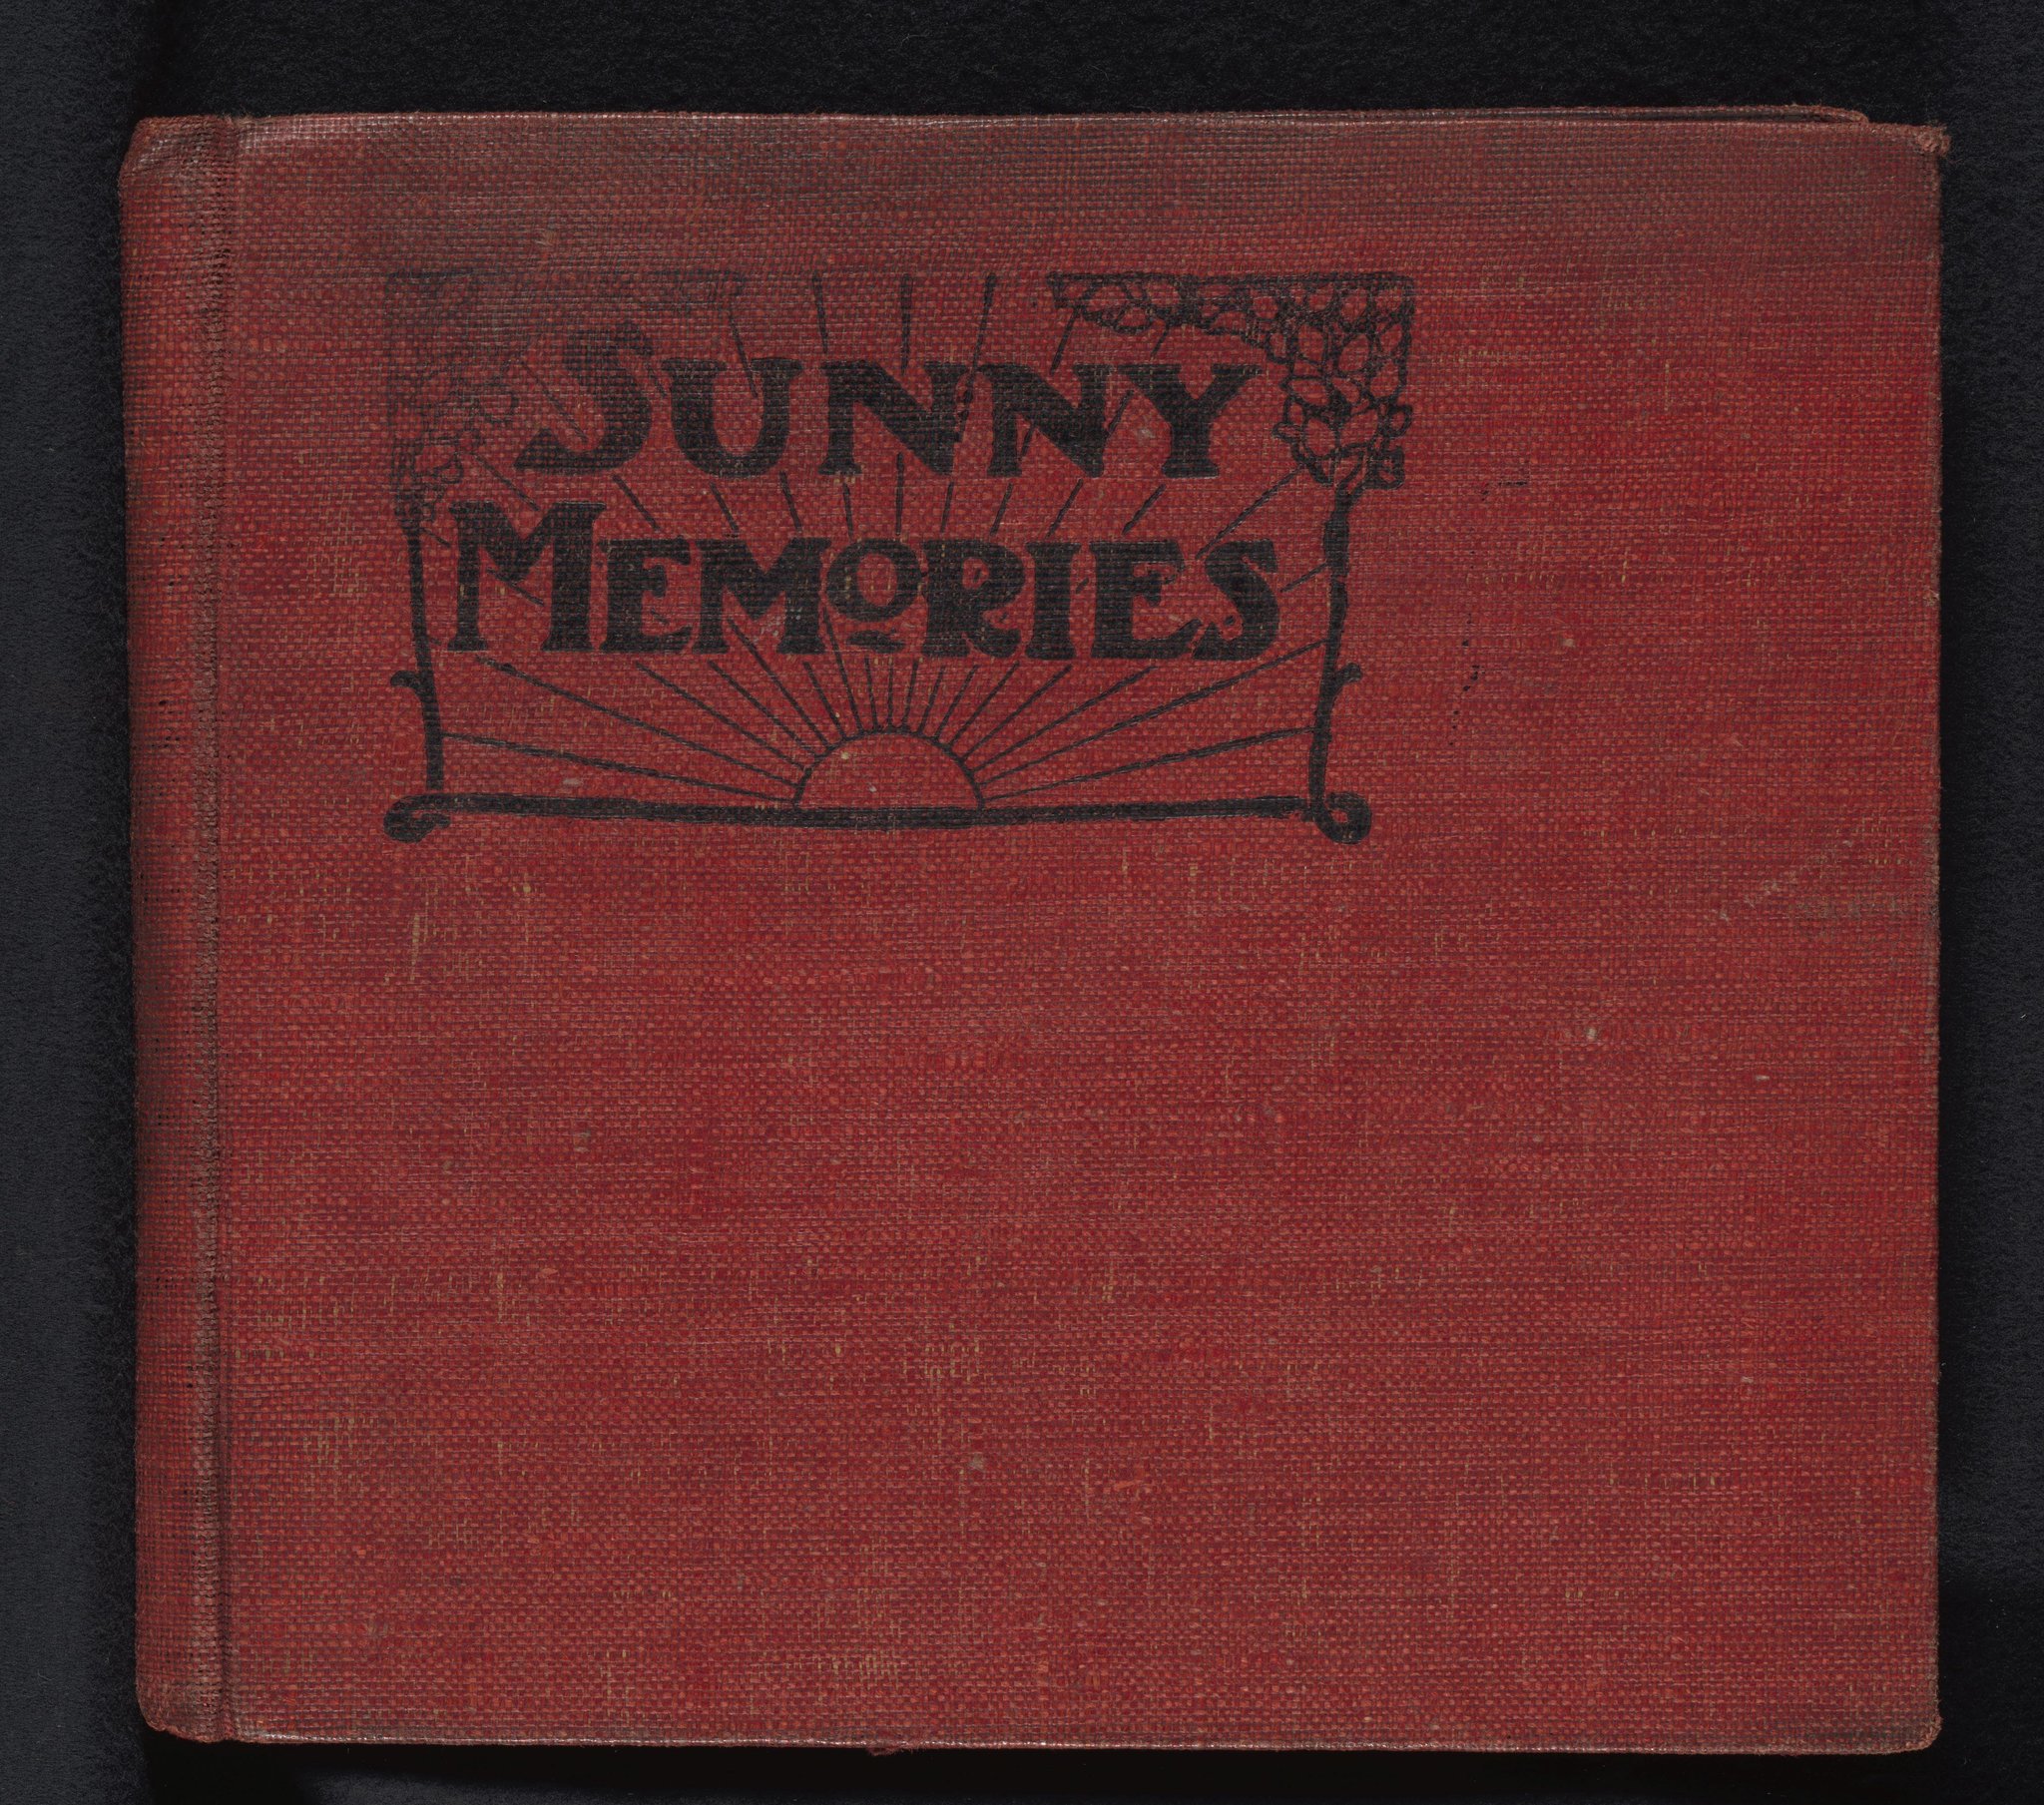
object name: photograph album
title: Reisalbum van een Nederlandse familie met bezienswaardigheden in Europa, Egypte en New York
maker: Anonymous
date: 1906-1909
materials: cardboard, linen, paper, photographic support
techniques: gelatin silver print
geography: amsterdam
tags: travelling; tourism, netherlands, italy, germany, new york (city), france, amsterdam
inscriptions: inscription: ‘L.&H. 21’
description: Fotoalbum in rode linnen band met op het voorplat de titel 'Sunny Memories' gedrukt. Het album bevat 12 dikke kartonnen bladen in verschillende kleuren. Elke pagina heeft 4 passe-partouts, 2 rechthoekige en 2 ovaalvormige. In totaal bevat het album 96 foto's met Engelstalige onderschriften. Het zijn opnames door een amateurfotograaf van reizen door onder meer Frankrijk, Duitsland, Italië, Schotland, Egypte en de Verenigde Staten. Deze werden ondernomen van oktober 1902 tot september 1906 door een ouder en een jonger echtpaar. Van dit laatste stel is ook een trouwfoto opgenomen, gemaakt in Amsterdam, vermoedelijk hun thuisbasis. Voorts zijn er opnames van landgoed (of: villa?) Fidelio in 's-Graveland. Mogelijk kan het album in verband worden gebracht met de familie Hennipman, aangezien deze naam zichtbaar is op één van de foto's. De afdrukken zijn niet in chronologische volgorde opgeplakt maar door elkaar heen. Reden waarom dit album vermoedelijk pas in 1906 of later is samengesteld.